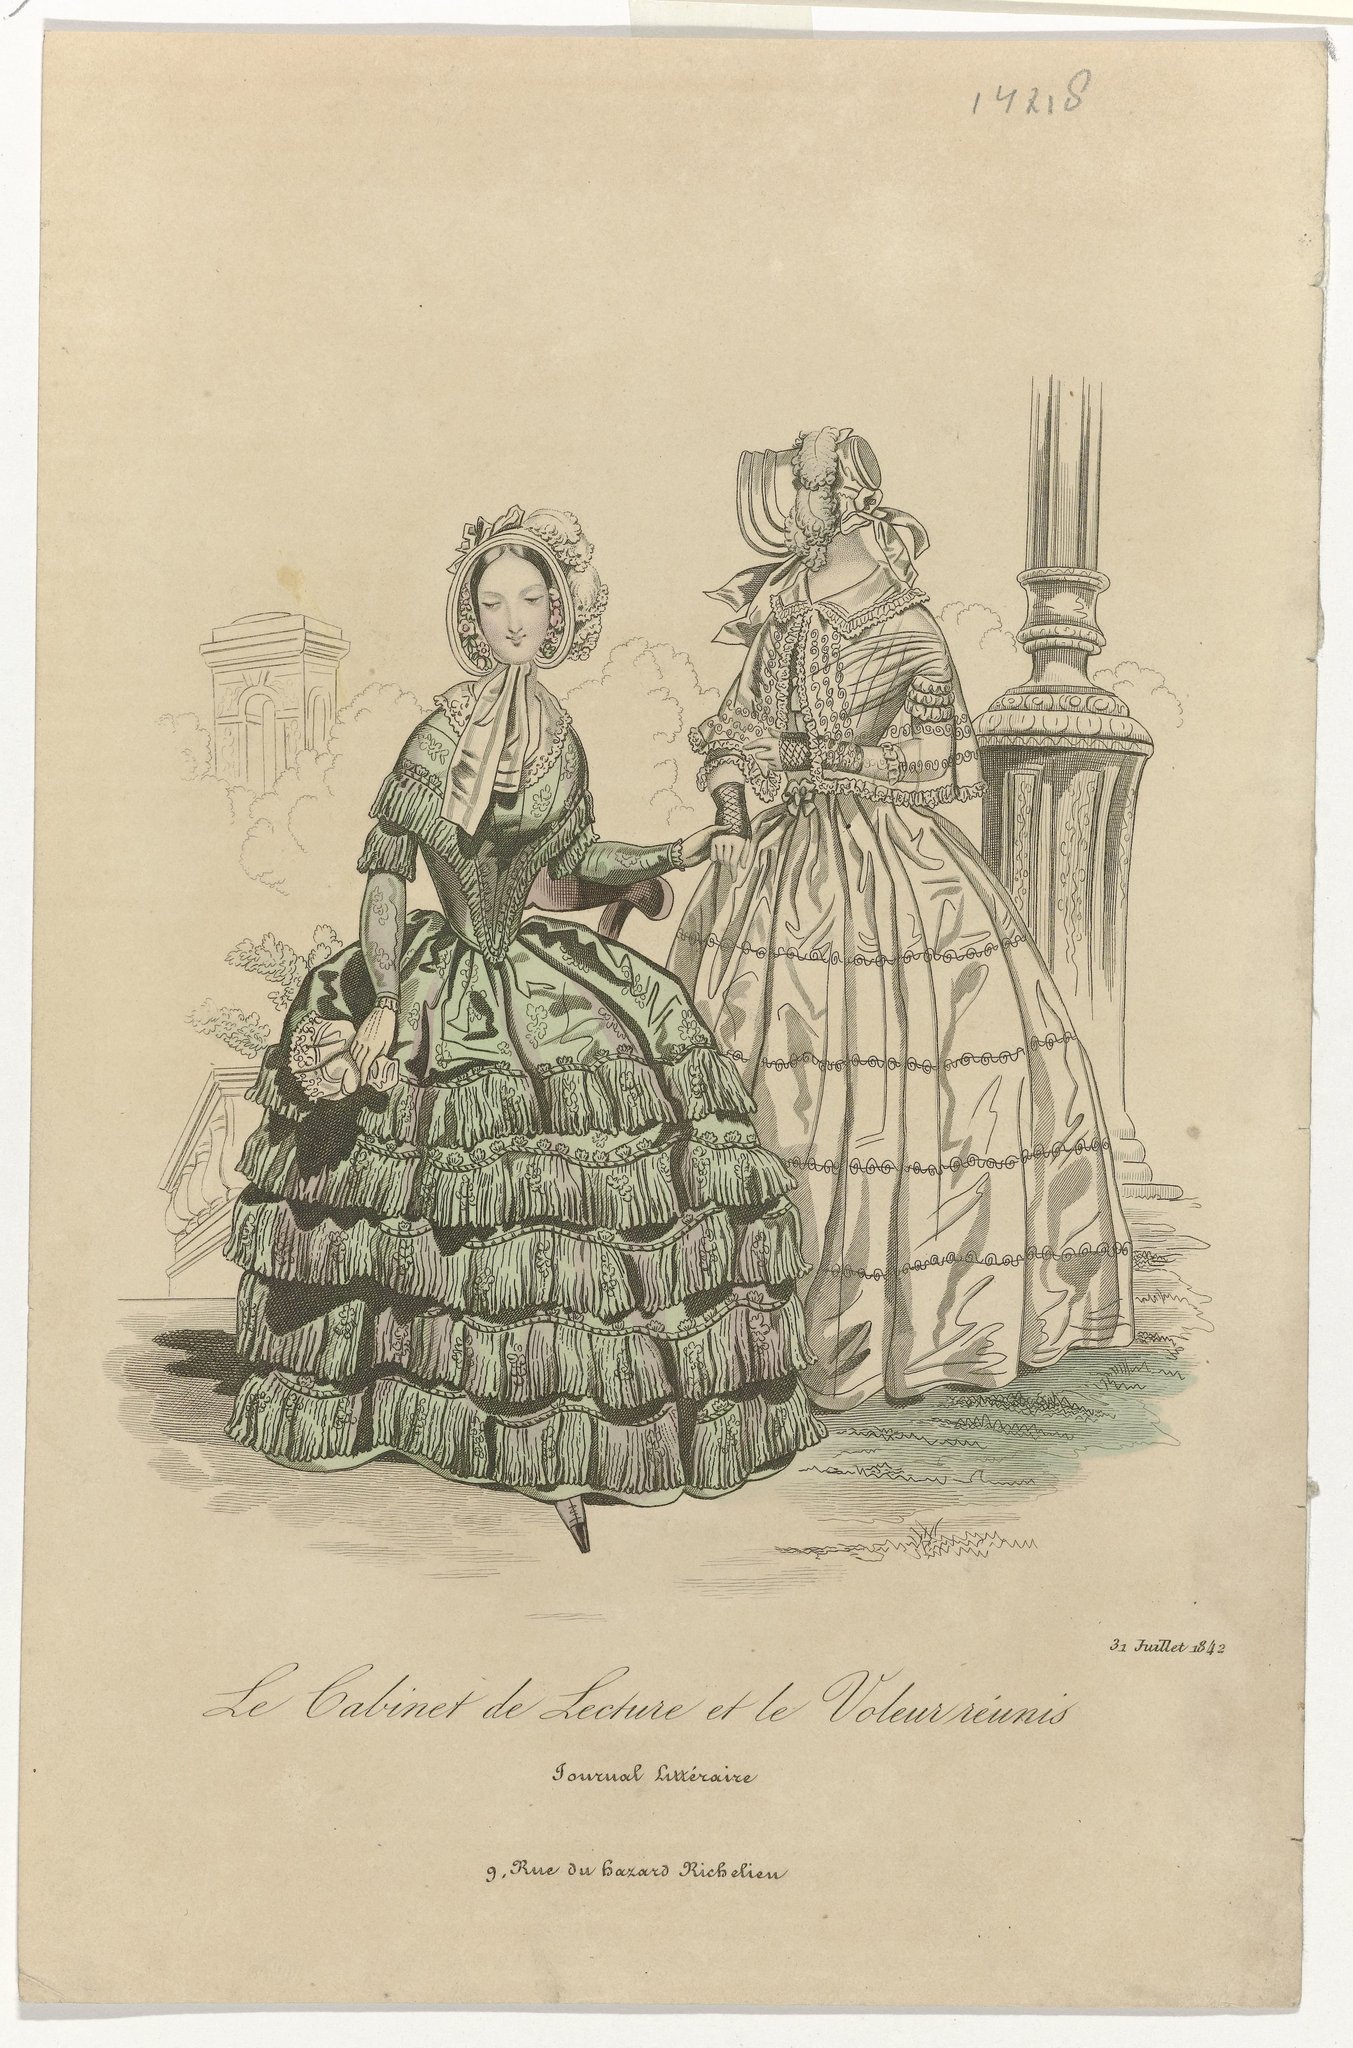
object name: fashion print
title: Le Cabinet de Lecture et le Voleur réunis, 31 juillet 1842 : Journal littéraire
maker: Anonymous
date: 1842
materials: paper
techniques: engraving, hand coloring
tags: handkerchief (+ women's clothes), gloves, mittens (long gloves) (+ women's clothes), gloves, mittens (mitaines) (+ women's clothes), clothing for the upper part of the body (mantelet) (+ women's clothes), fashion plates, head-gear: hat (+ women's clothes), shoes, sandals (+ women's clothes), dress, gown (+ women's clothes)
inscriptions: title: ‘Le Cabinet de Lecture et le Voleur réunis / Journal Littéraire’, address: ‘9, Rue du Hazard Richelieu’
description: Twee vrouwen op straat, op de achtergrond een triomfboog. Links: japon met bladmotief, versierd met gerimpelde stroken stof. Lange mouwen. Rechts: japon met geplooid lijfje en driekwart mouwen. Doorzichtige schoudermantel met kraag. Prent uit het modetijdschrift Le Cabinet de Lecture (1829-1842).